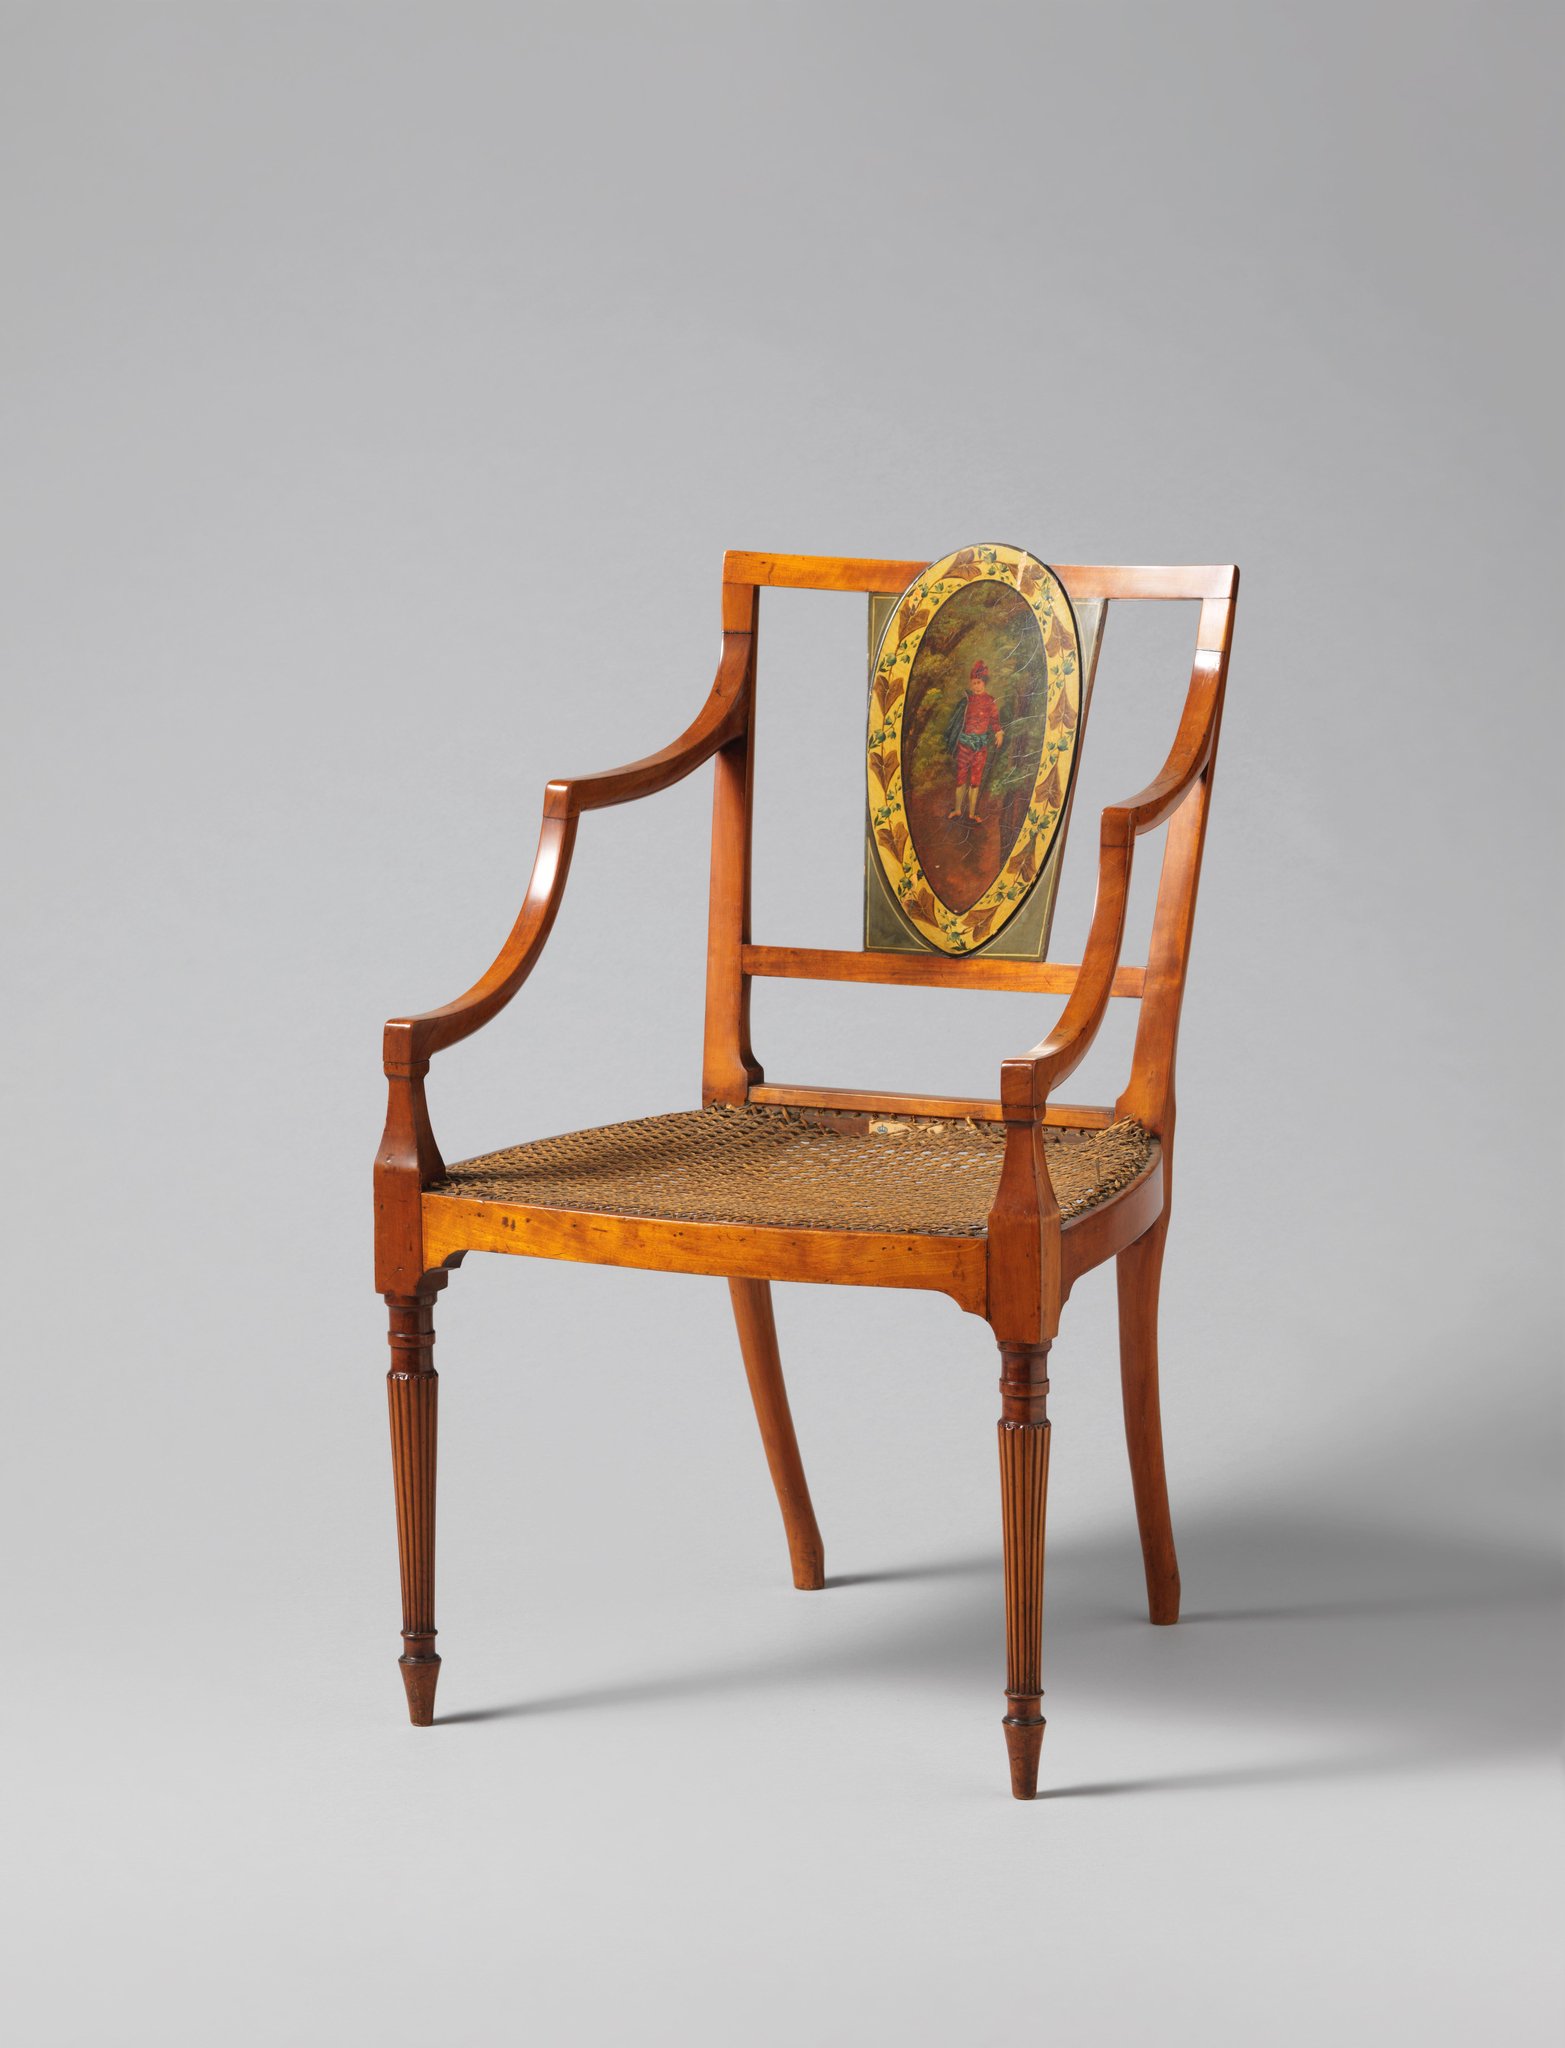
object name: suite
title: Stoel van gedeeltelijk gefineerd en beschilderd satijnhout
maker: Anonymous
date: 1785-1800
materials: rattan, wood, textile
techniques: painted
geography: great britain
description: Gedeeltelijk gefineerde en beschilderde satijnhouten stoelen, rustend op gecanneleerde conische gelede voorpoten en achterwaarts gebogen achterpoten. De verbinding tussen de armleggerstutten en de flauw gebogen armleggers is C-vormig. De rug is flauw gebogen en in het midden versierd met een verticale verbinding, waarop geschilderde medaillons, vrij naar 18de-eeuwse voorstellingen. De zitting is met riet bespannen en voorzien van losse geborduurde kussens. Zie tevens: BK-16137-a t/m e.